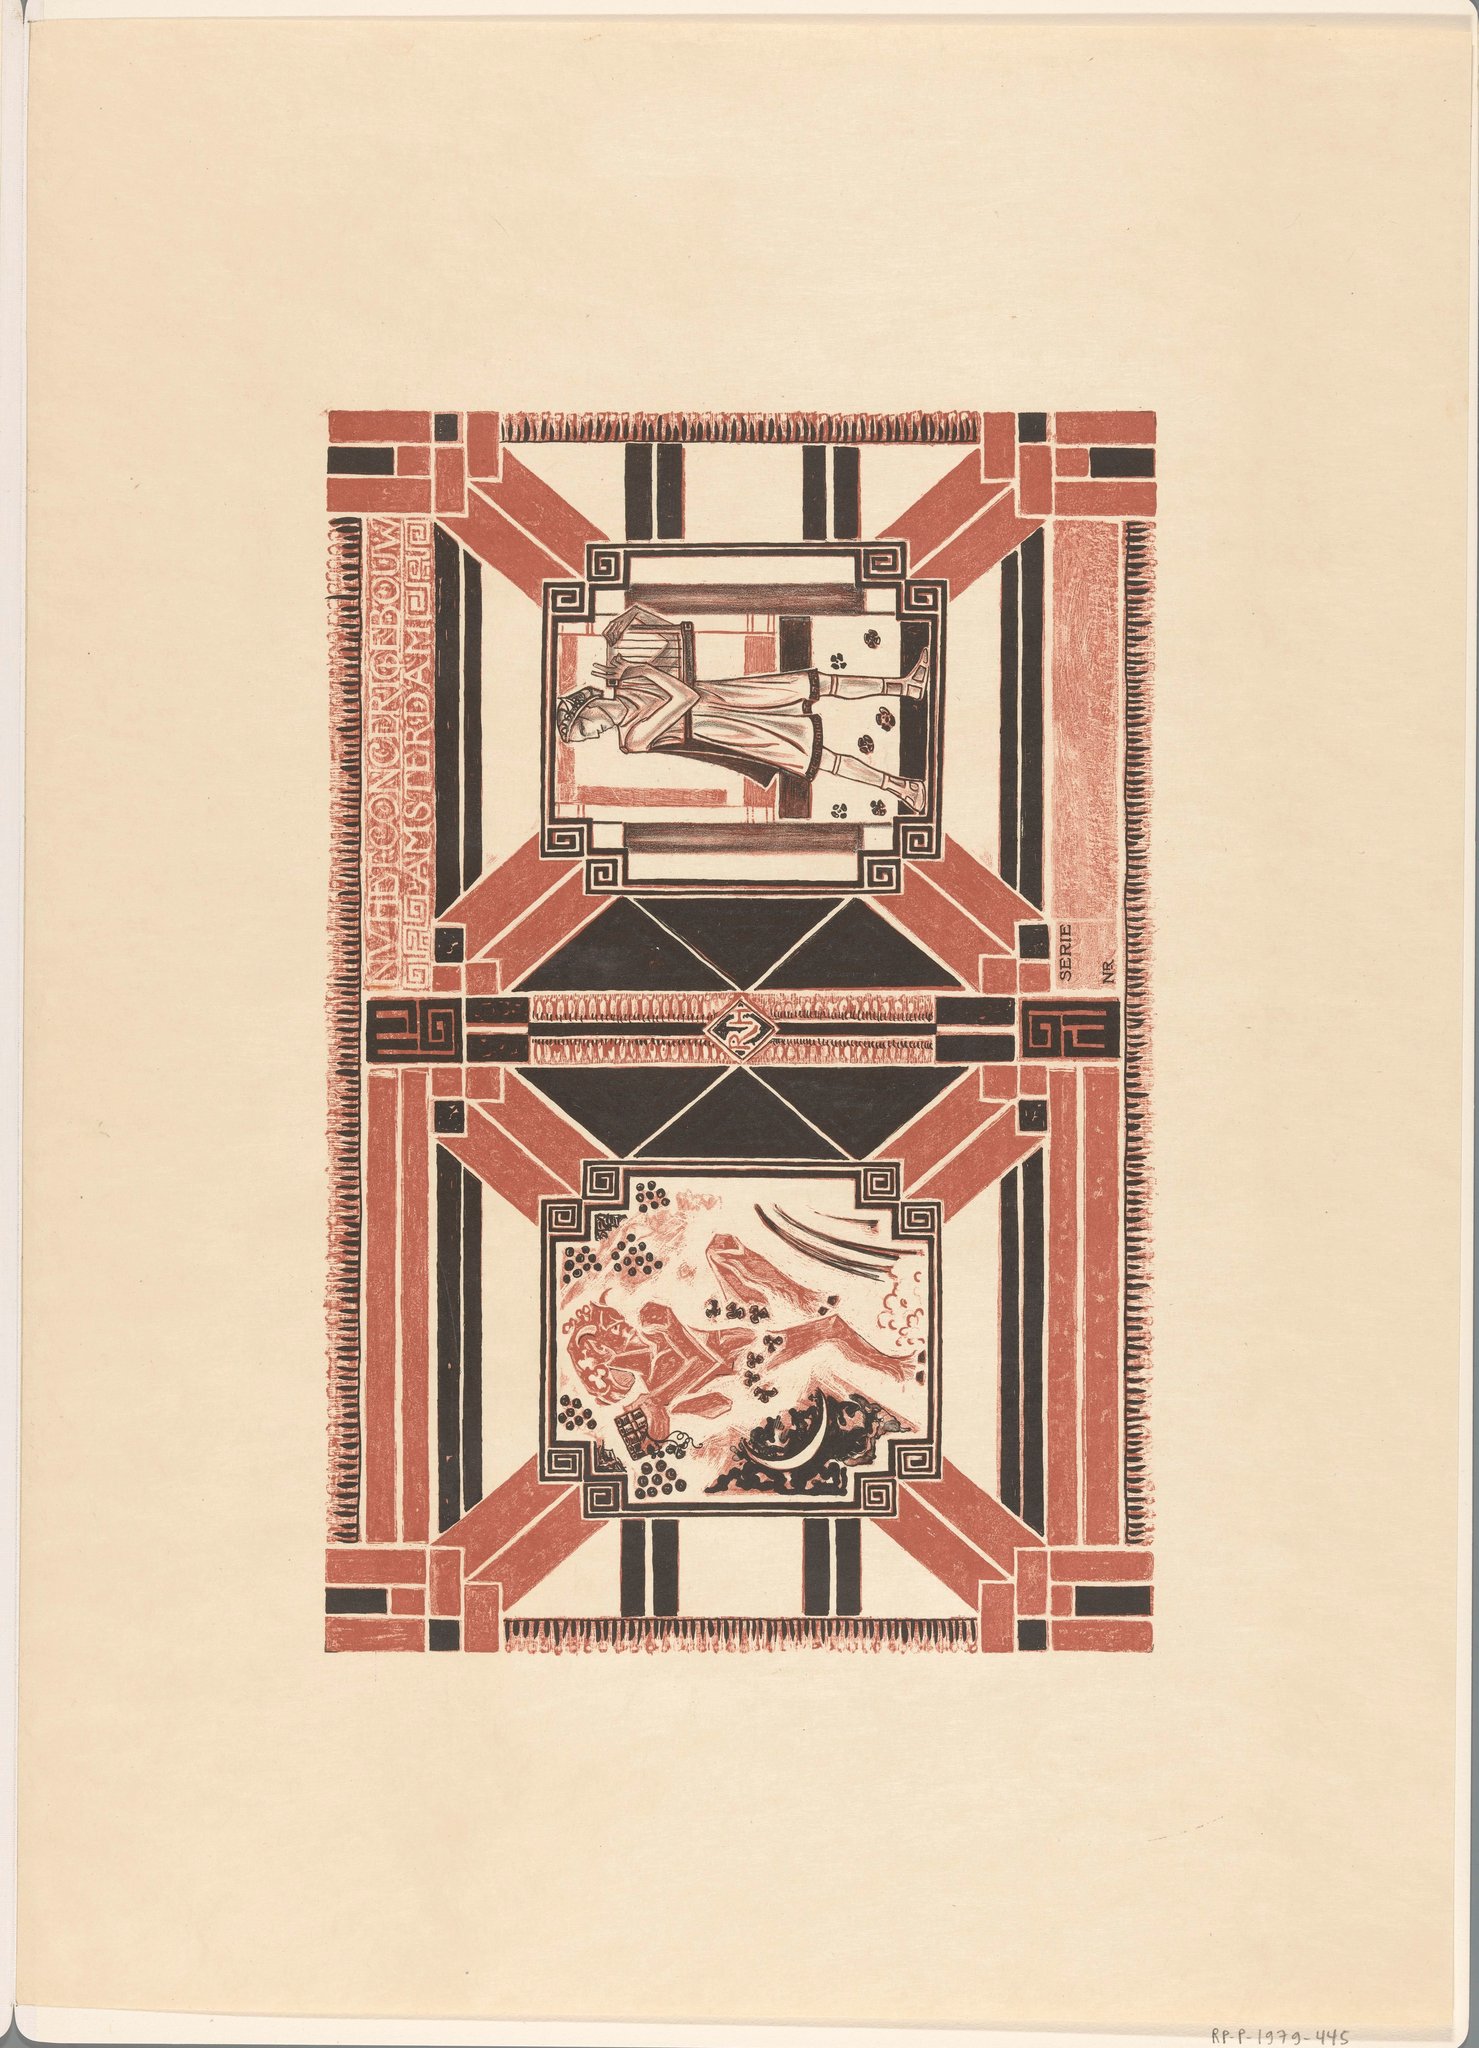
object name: design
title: Omslagontwerp voor: Programma van het Concertgebouw Amsterdam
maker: richard nicolaüs roland holst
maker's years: 1868-1938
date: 1921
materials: paper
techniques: lithograph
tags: panpipes, satyr(s) (in general), apollo playing the lyre, apollo citharoedus, (story of) marsyas, bunch of grapes, dulcimer, zither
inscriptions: collector's mark: Lugt 2228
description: Links een sater, vermoedelijk Marsyas, met een panfluit te midden van druiven. Rechts een figuur met een citer, vermoedelijk Apollo.